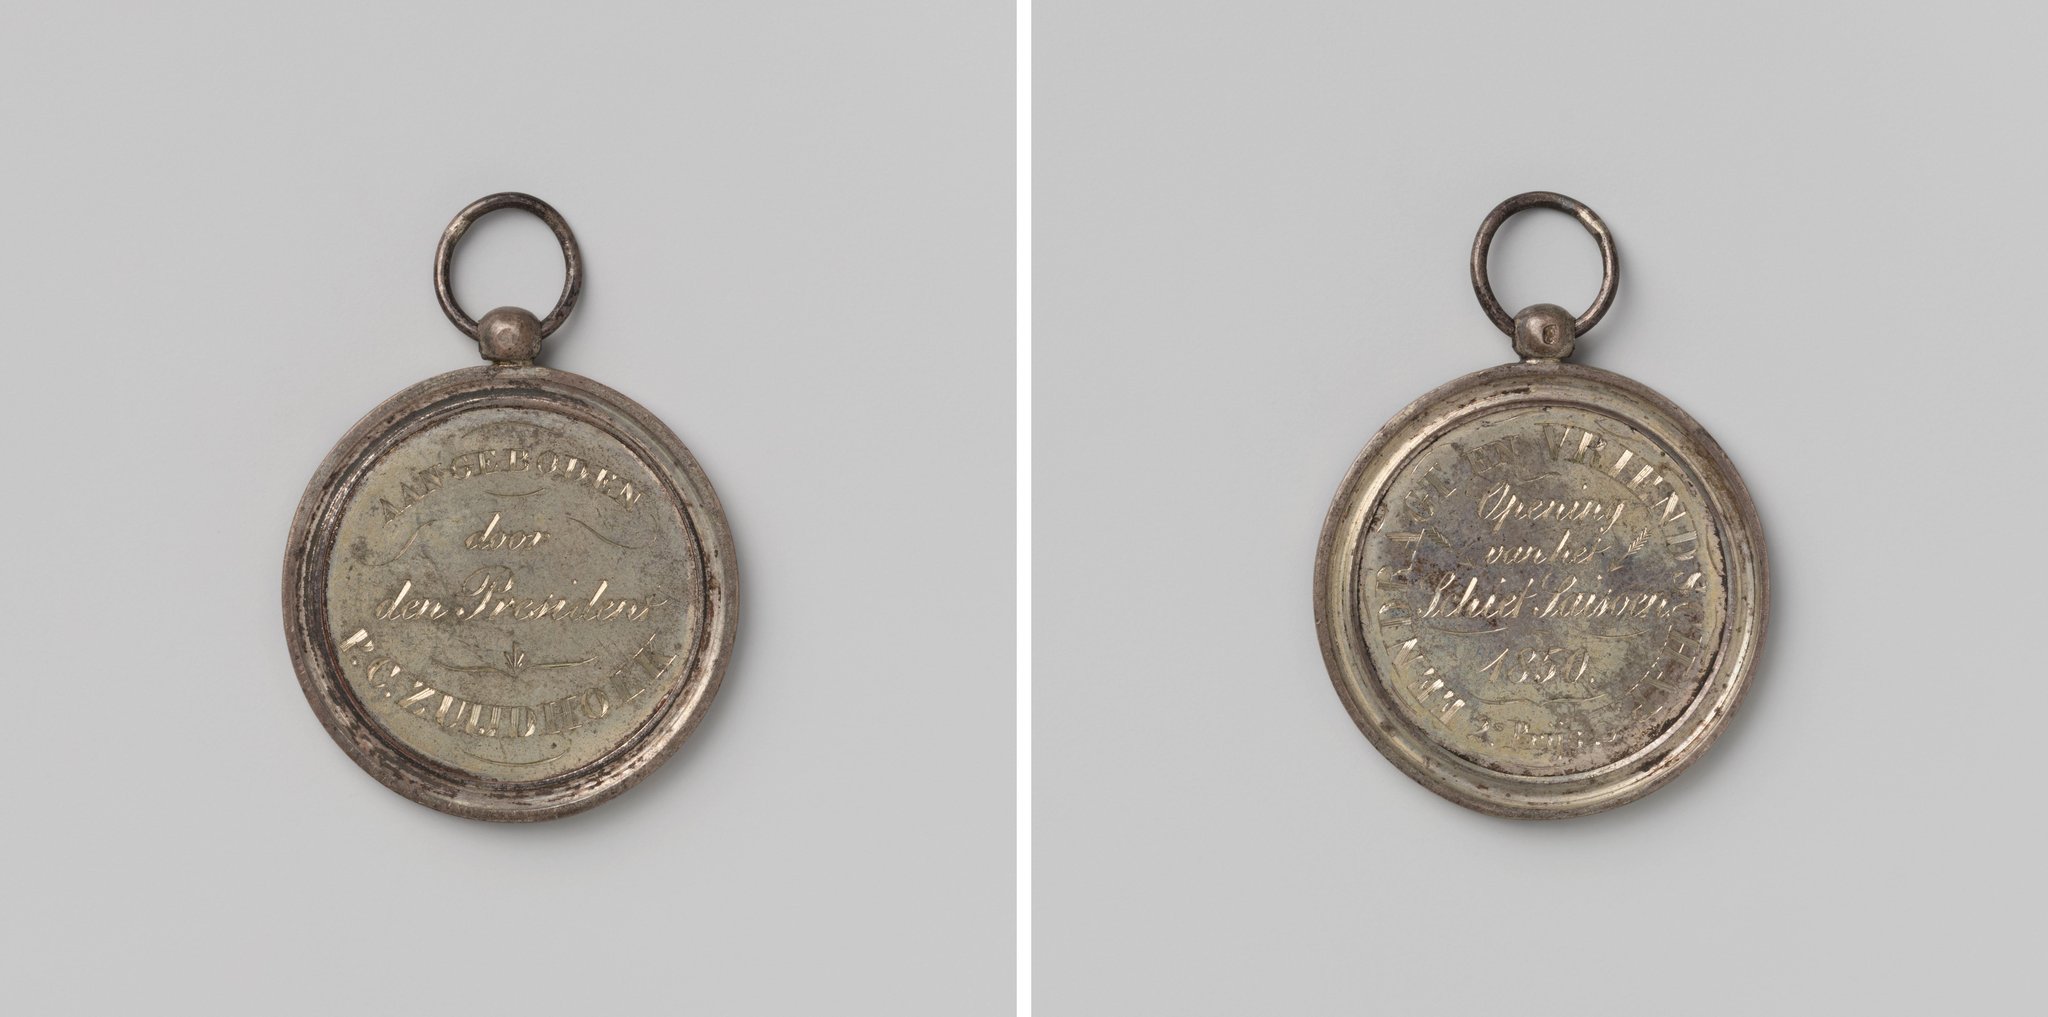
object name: marksman medal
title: Schuttersdoelen 'Eendracht en Vriendschap', tweede prijs bij de wedstrijden ter ere van de opening van het schietseizoen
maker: Anonymous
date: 1850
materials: silver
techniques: engraving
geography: amsterdam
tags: amsterdam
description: Zilveren penning aan draagoog en draagring. Voorzijde: opschrift binnen omschrift. Keerzijde: opschrift.